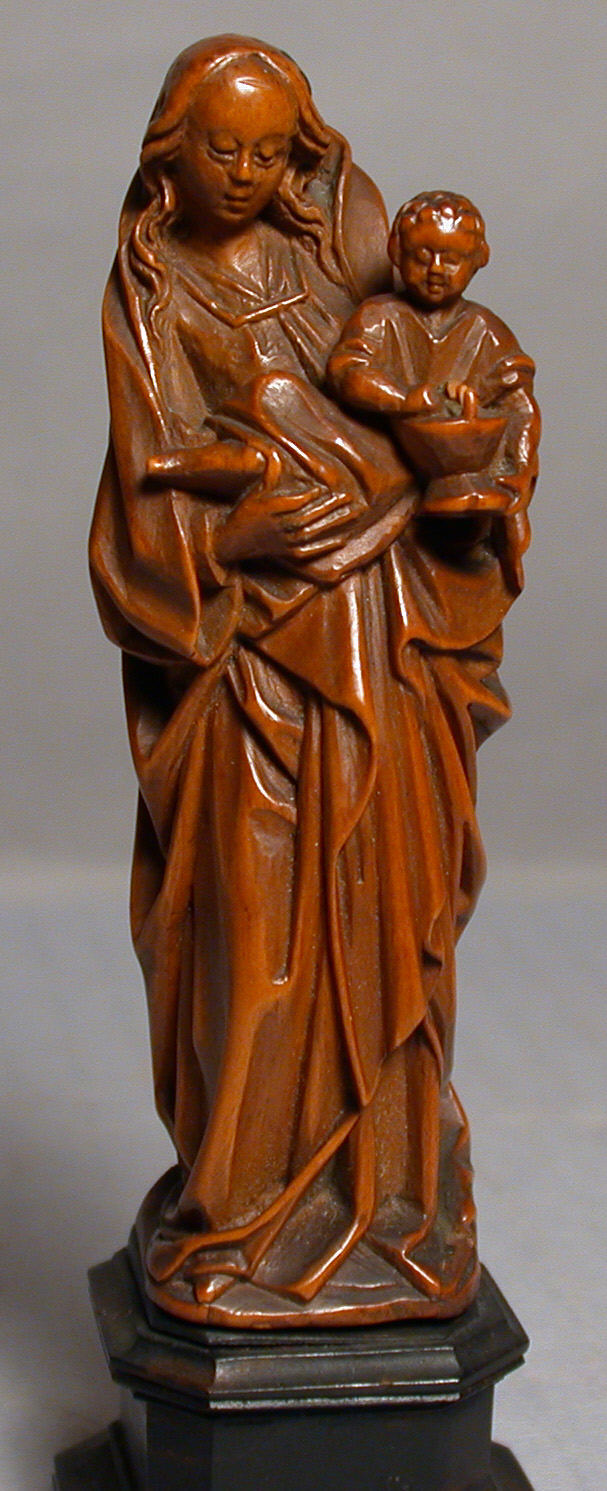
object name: sculpture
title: Statuette of the Virgin and Child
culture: franco-netherlandish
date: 1501-1533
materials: wood